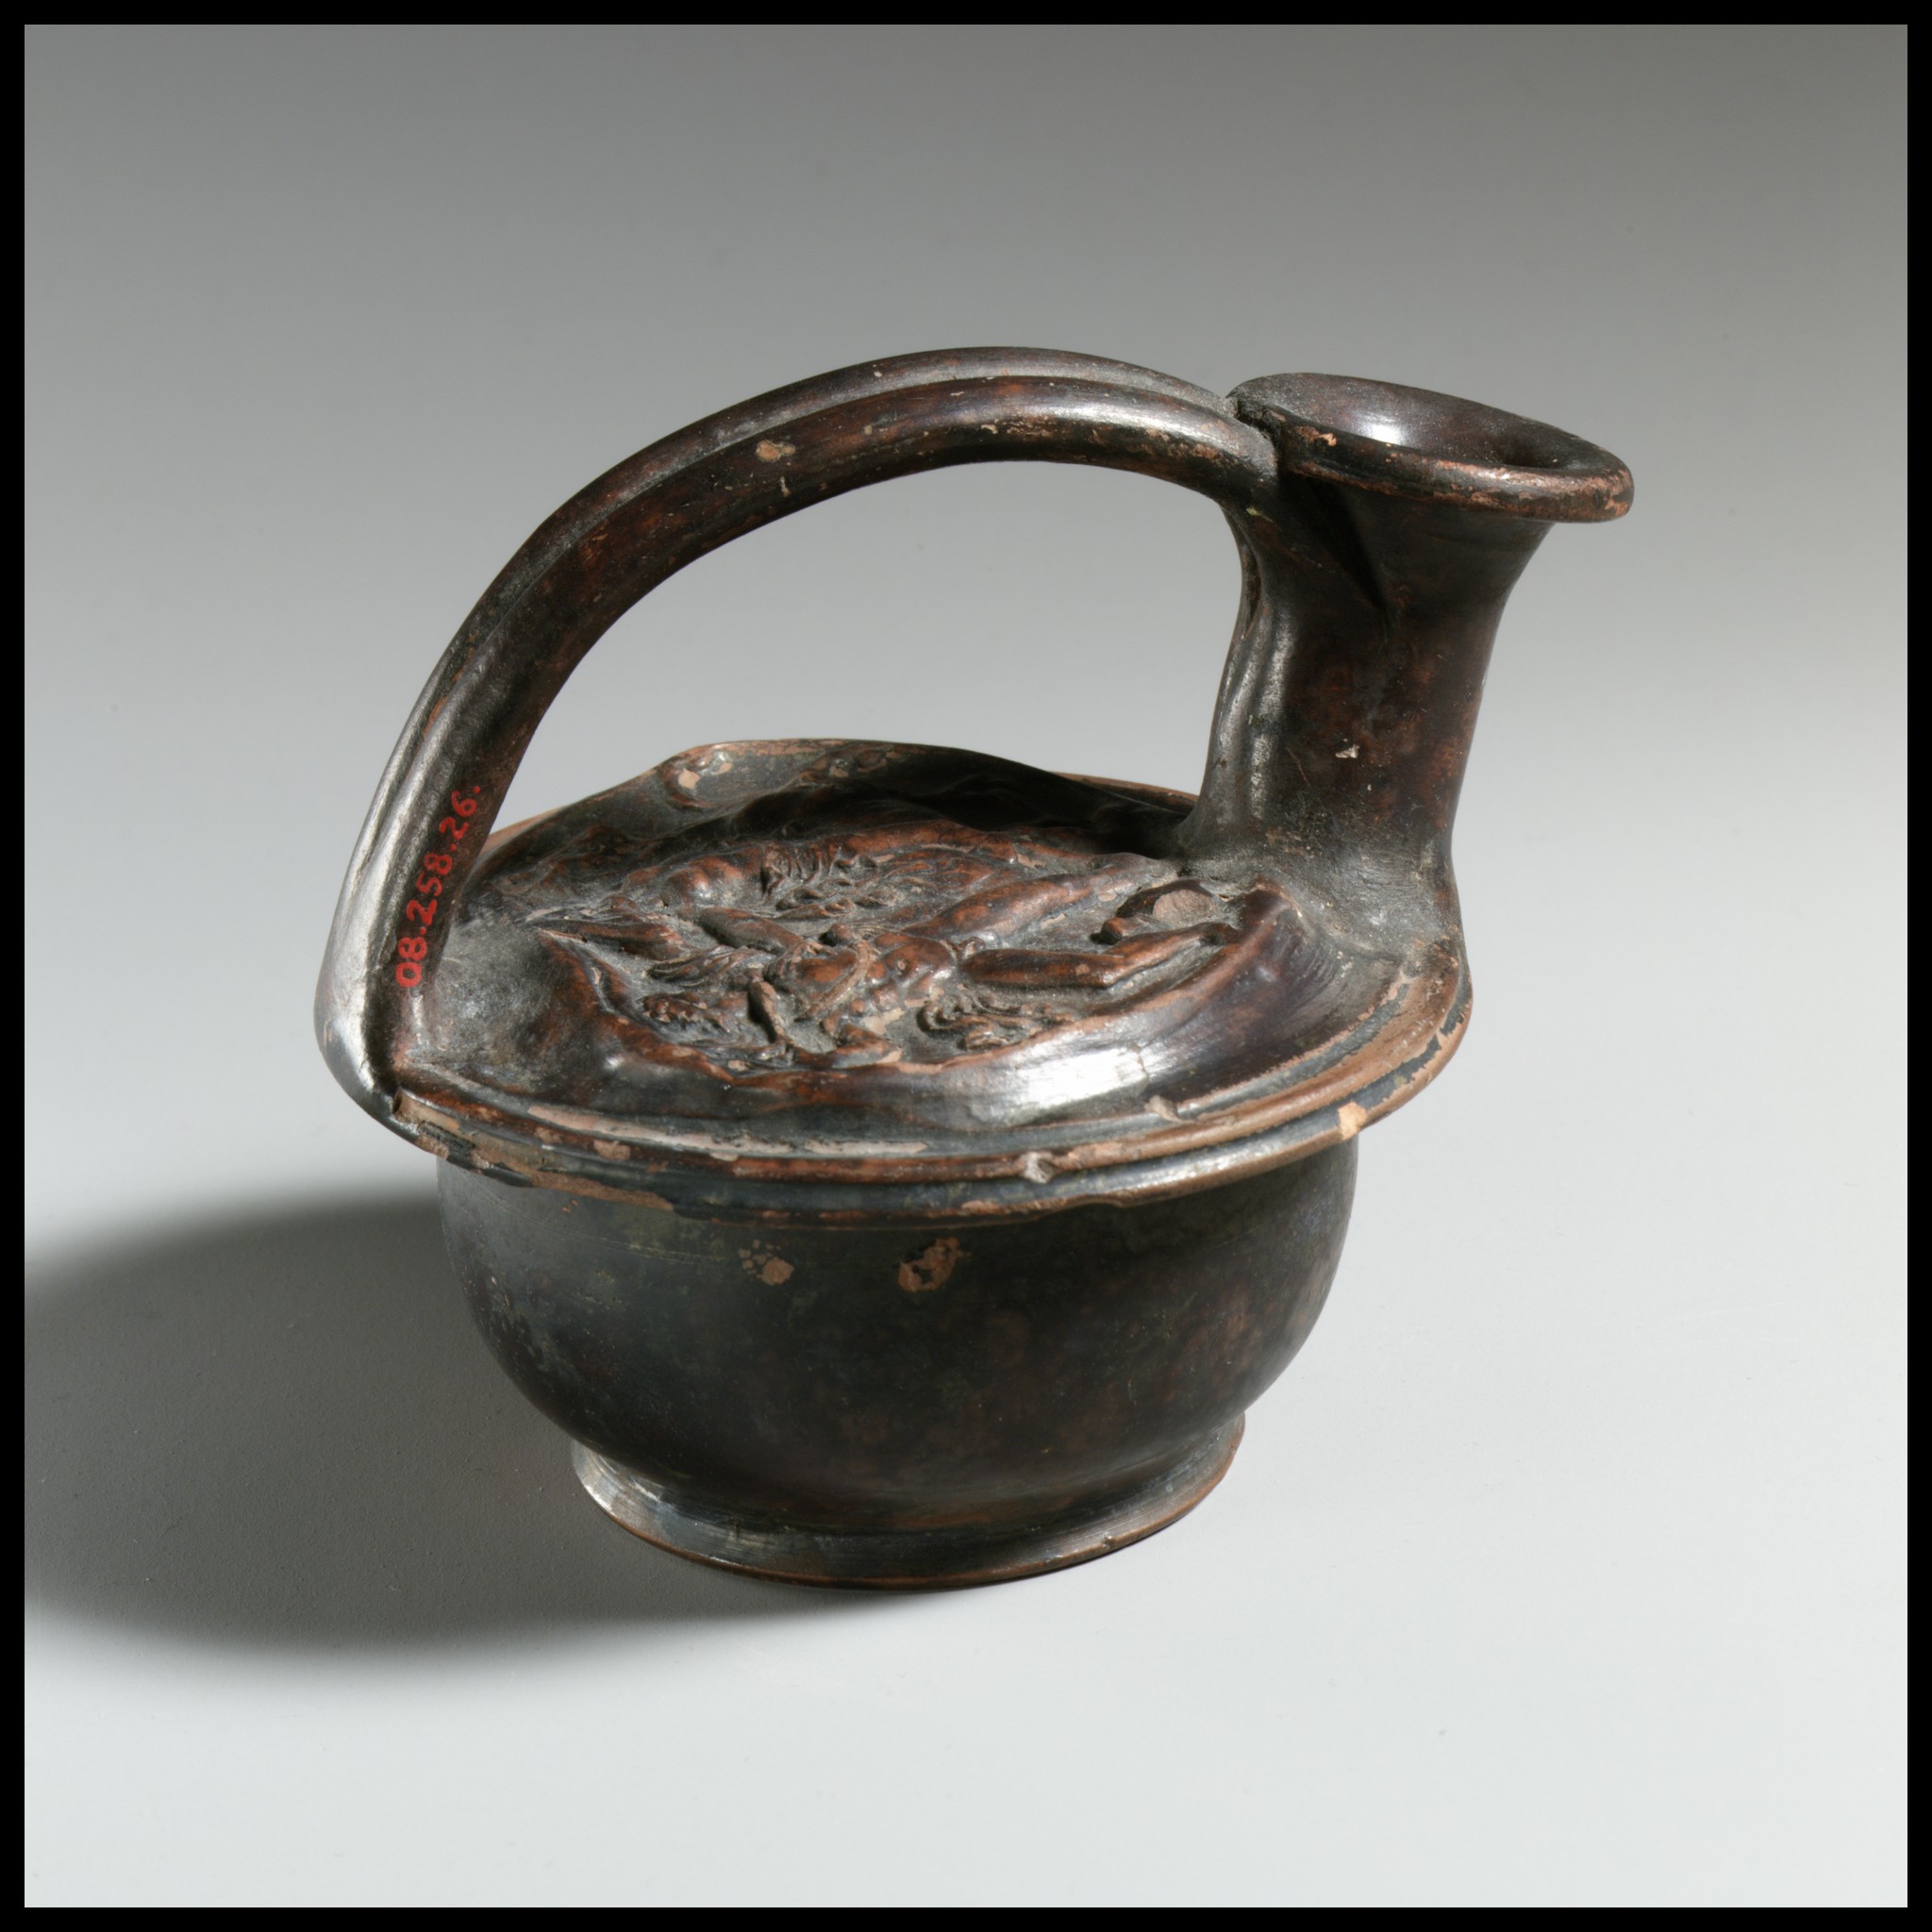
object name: askos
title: Terracotta askos (flask with a spout and handle over the top)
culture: greek or south italian or campanian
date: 400-301 BCE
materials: terracotta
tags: amazons